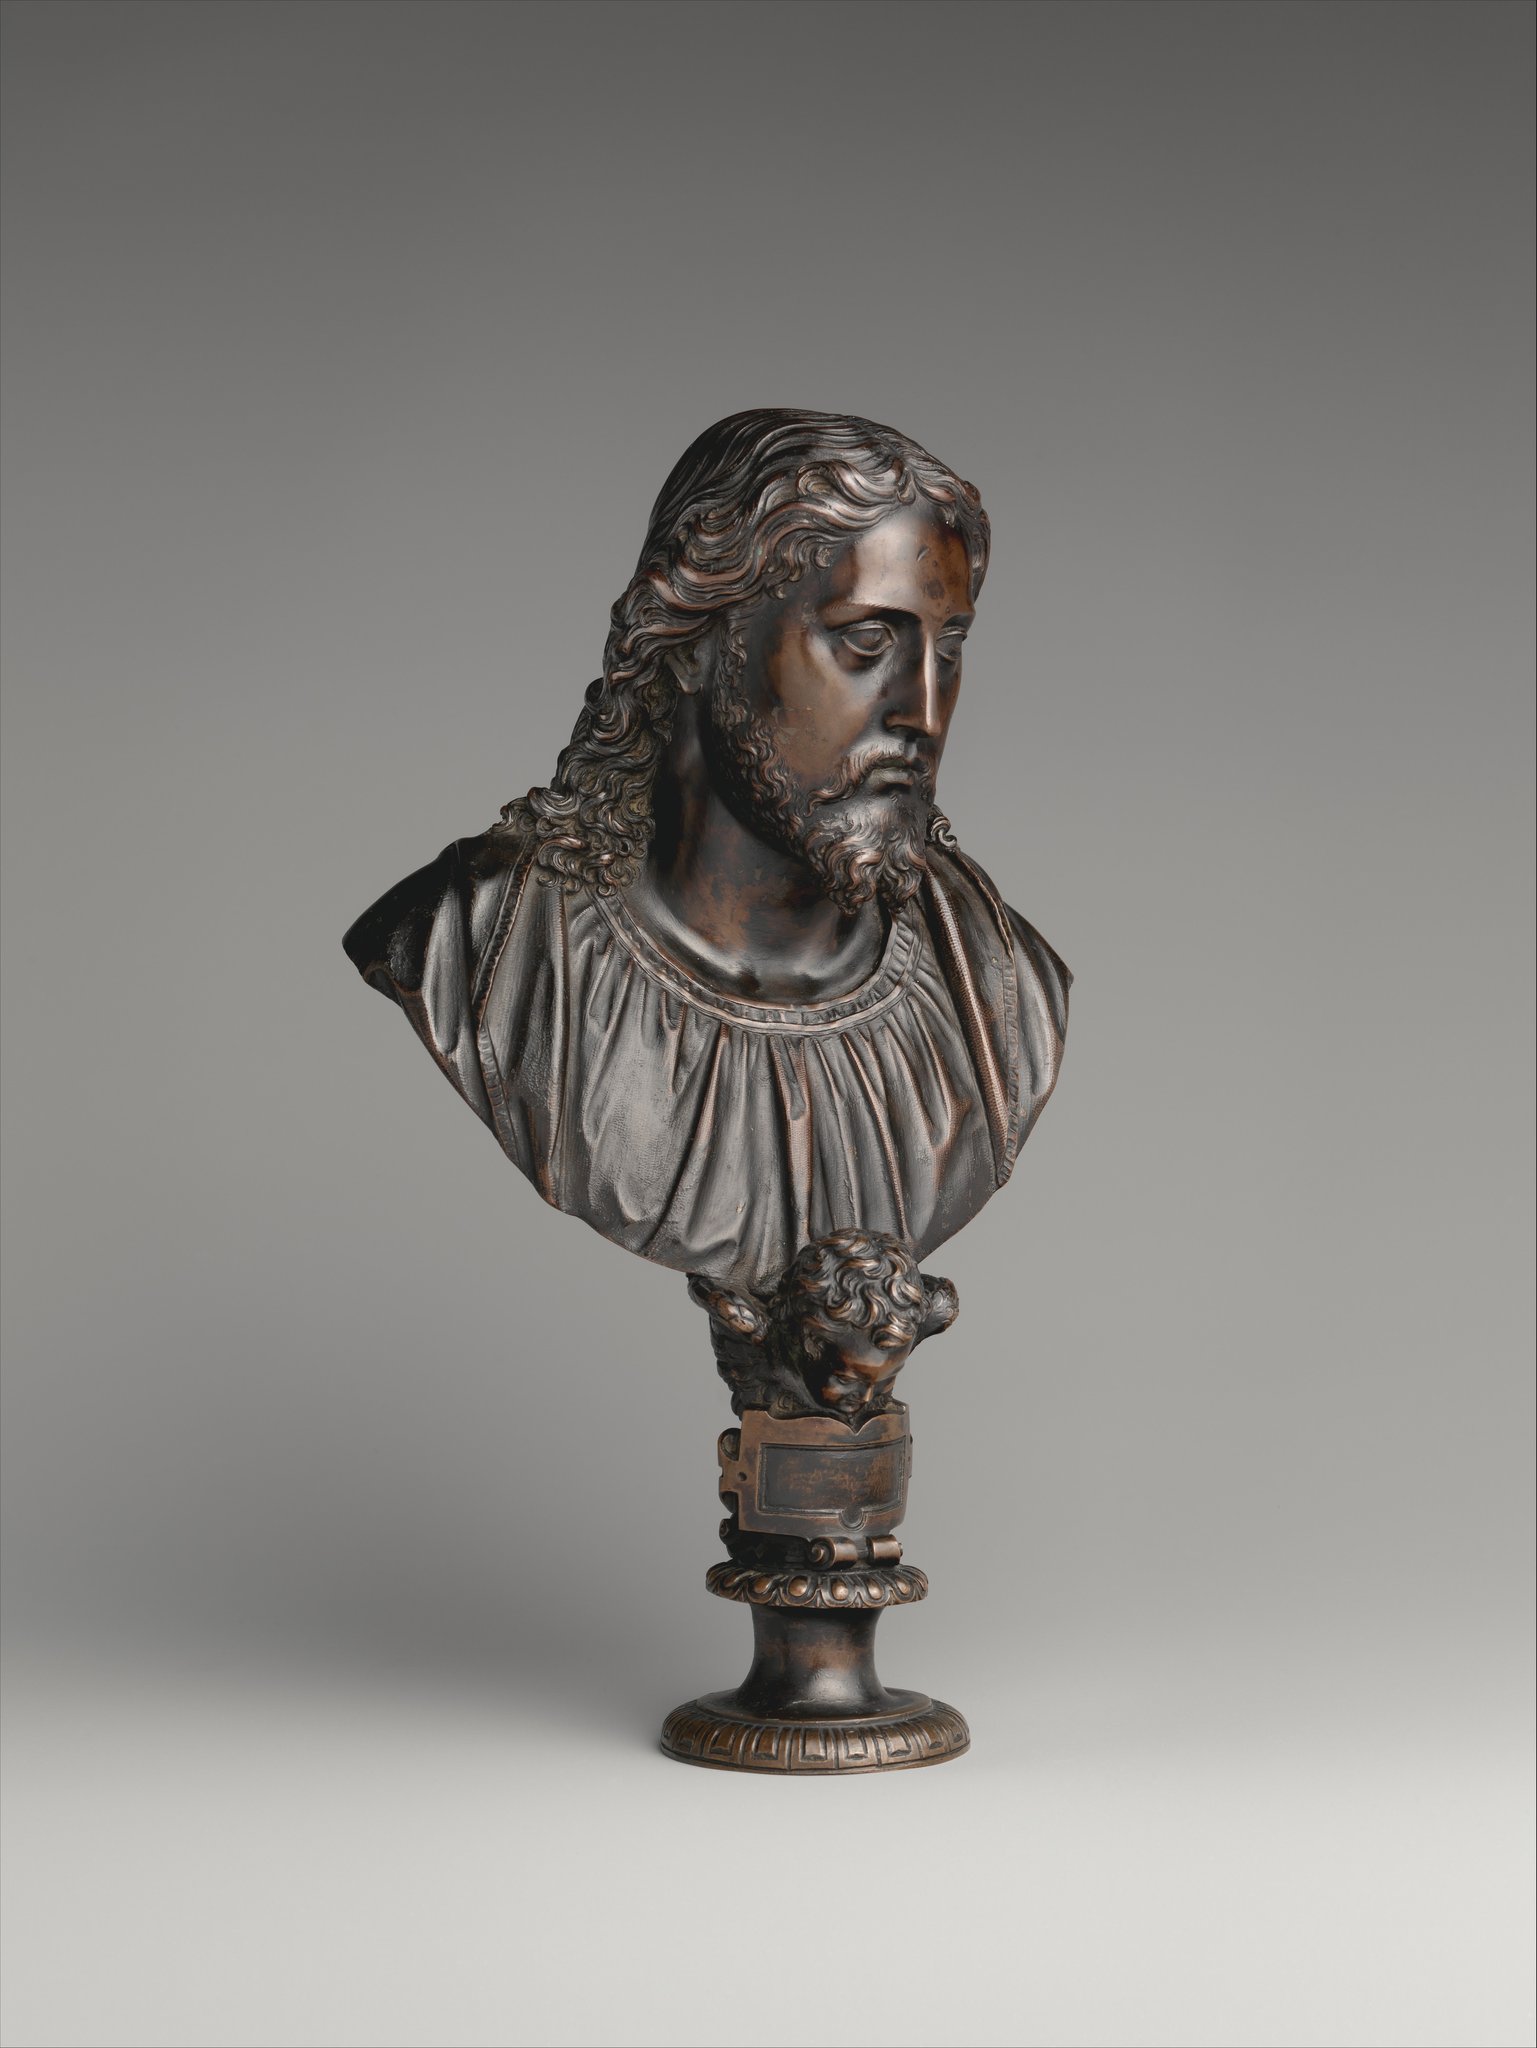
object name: bust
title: Bust of Christ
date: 1567-1600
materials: bronze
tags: portraits,christ